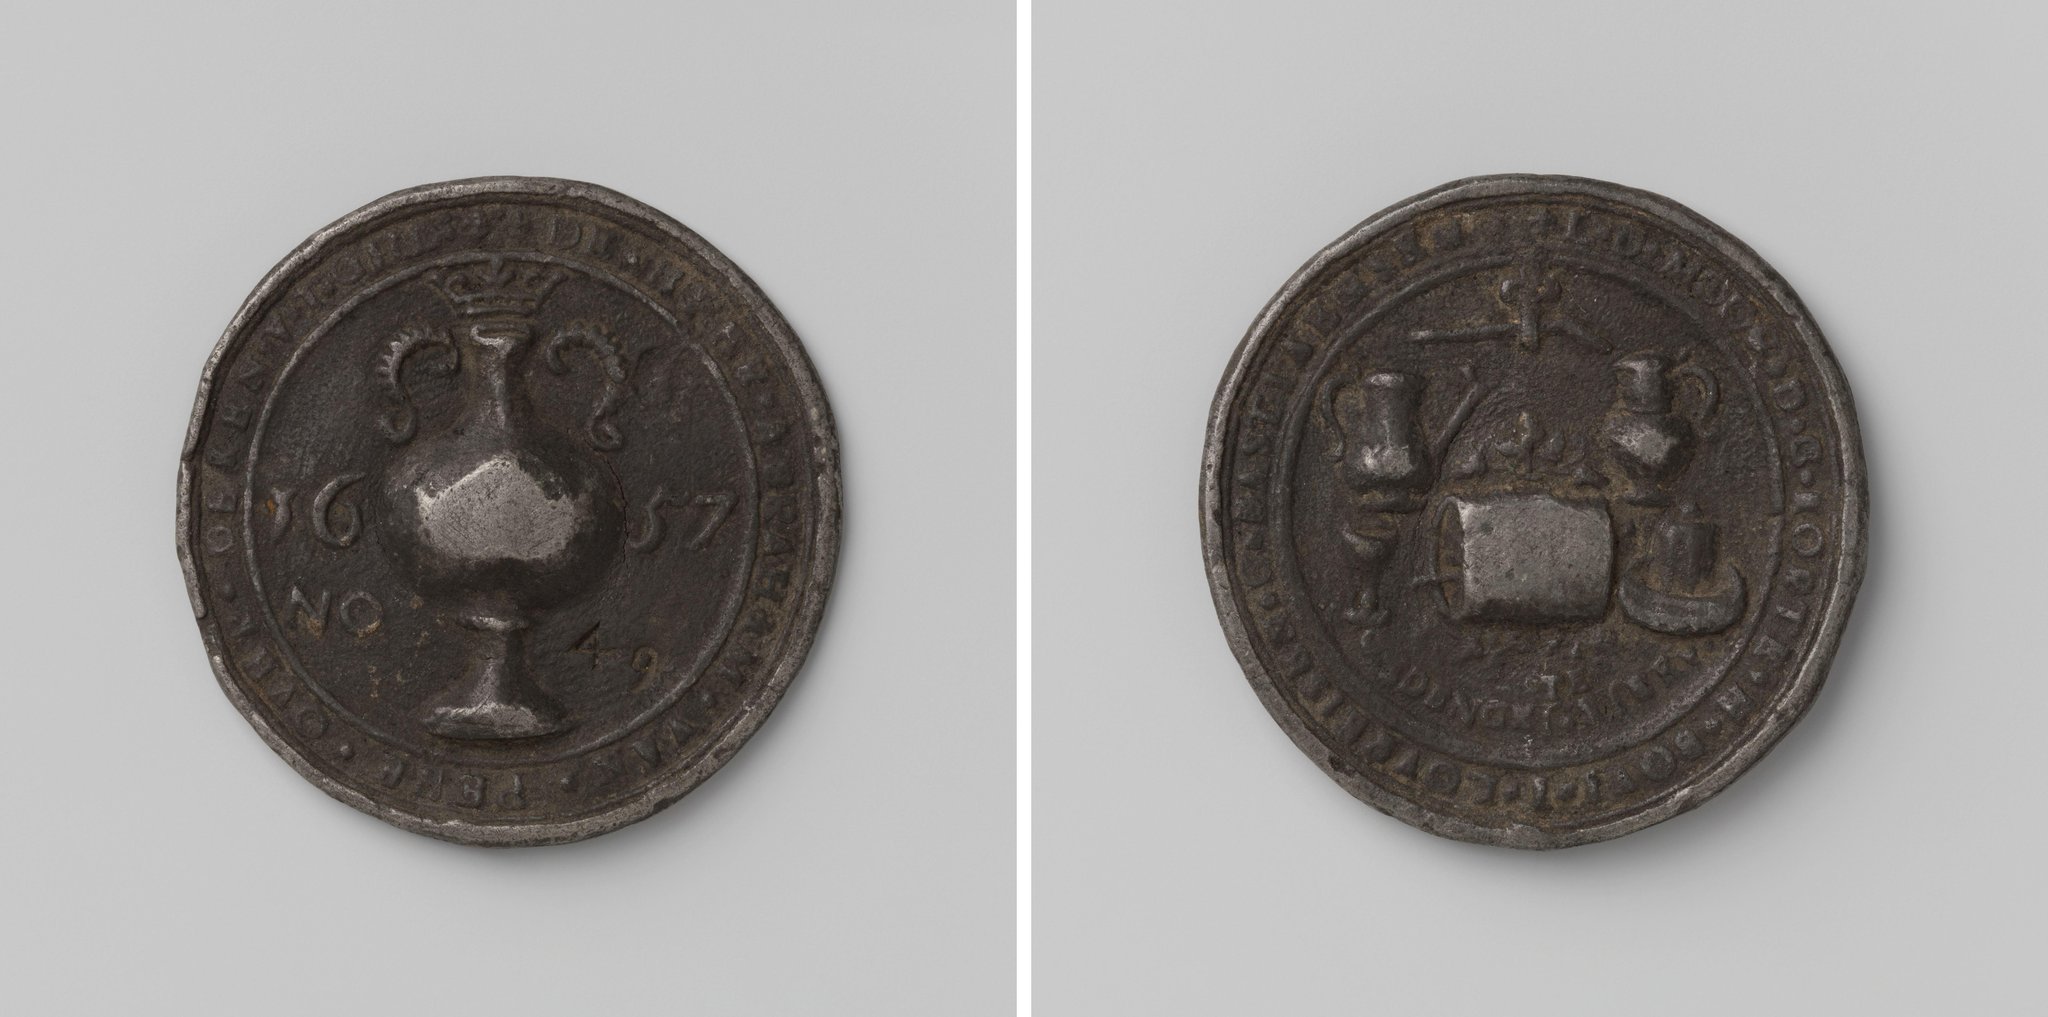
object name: funeral token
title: Tappersgilde van Vlissingen, begrafenispenning met no. 49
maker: Anonymous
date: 1657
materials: lead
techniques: casting, engraving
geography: flushing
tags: abraham van pere, flushing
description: Loden penning. Voorzijde: gekroonde fles tussen jaartal en opschrift No. 49 binnen omschrift. Keerzijde: vat op tap, omringd door loofwerk; daaromheen: tuitkan met opschrift, wijnglas, kan met een oor en schotel waarop bierglas boven opschrift binnen omschrift.